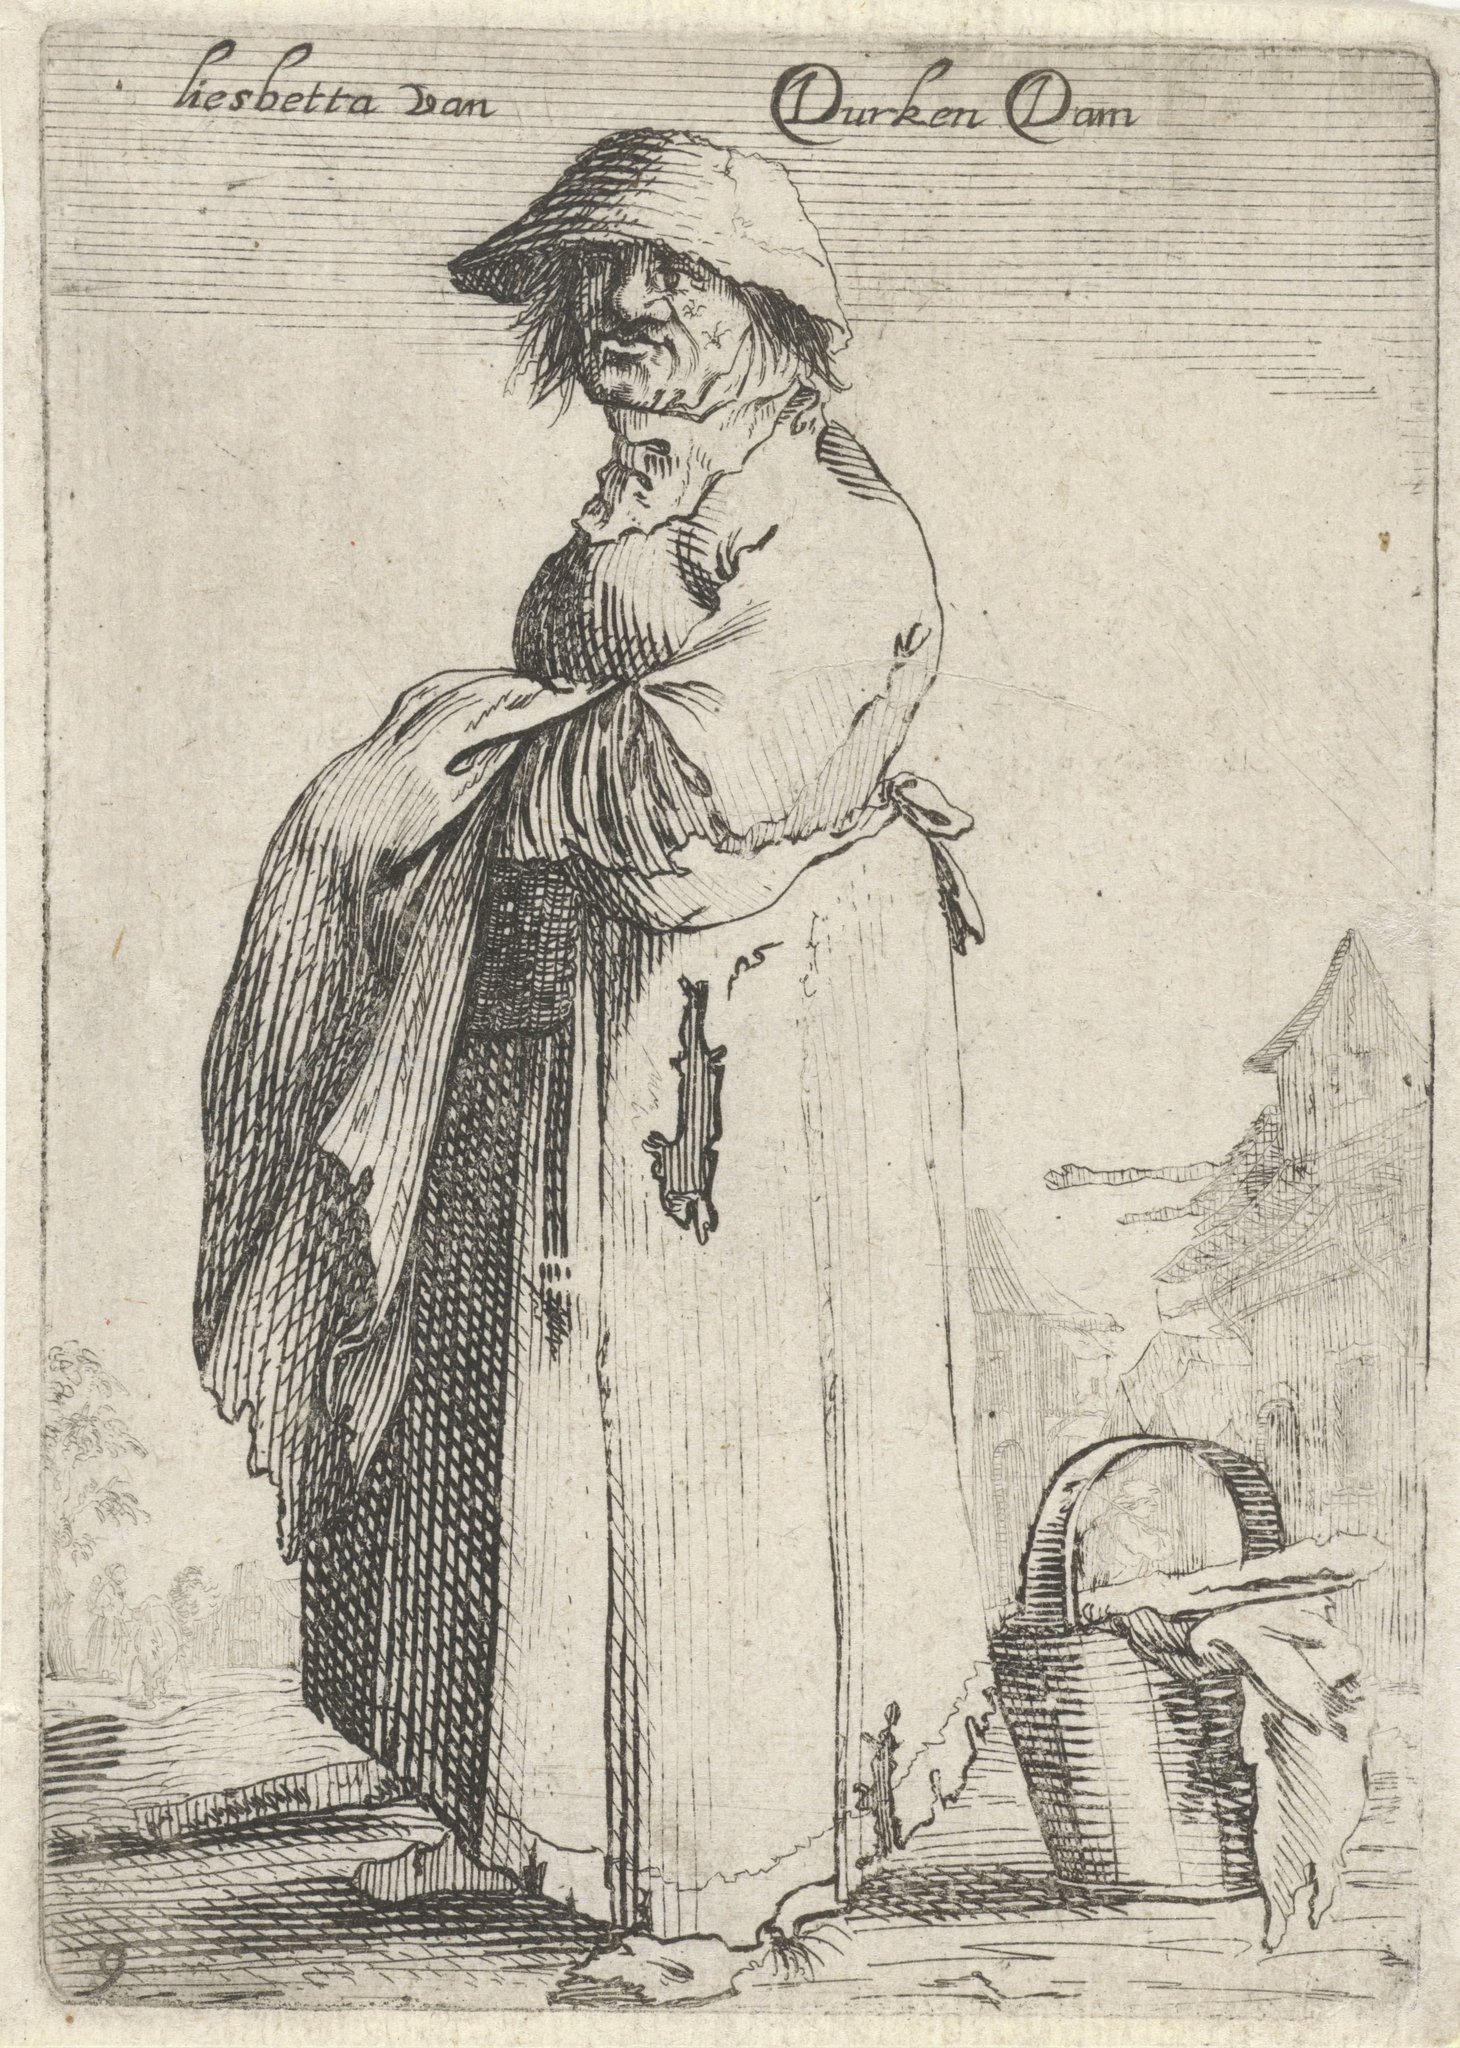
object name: print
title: liesbetta van Durken Dam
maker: Anonymous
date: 1630-1715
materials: paper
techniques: engraving, etching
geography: amsterdam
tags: wooden container: barrel, cask, bucket, farmers, textile fabric, cloth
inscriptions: collector's mark: Lugt 2228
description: Kopie naar prent uit de twaalfdelige serie "T'Leven Der Boeren" van Salomon Savery naar Pieter Jansz. Quast.